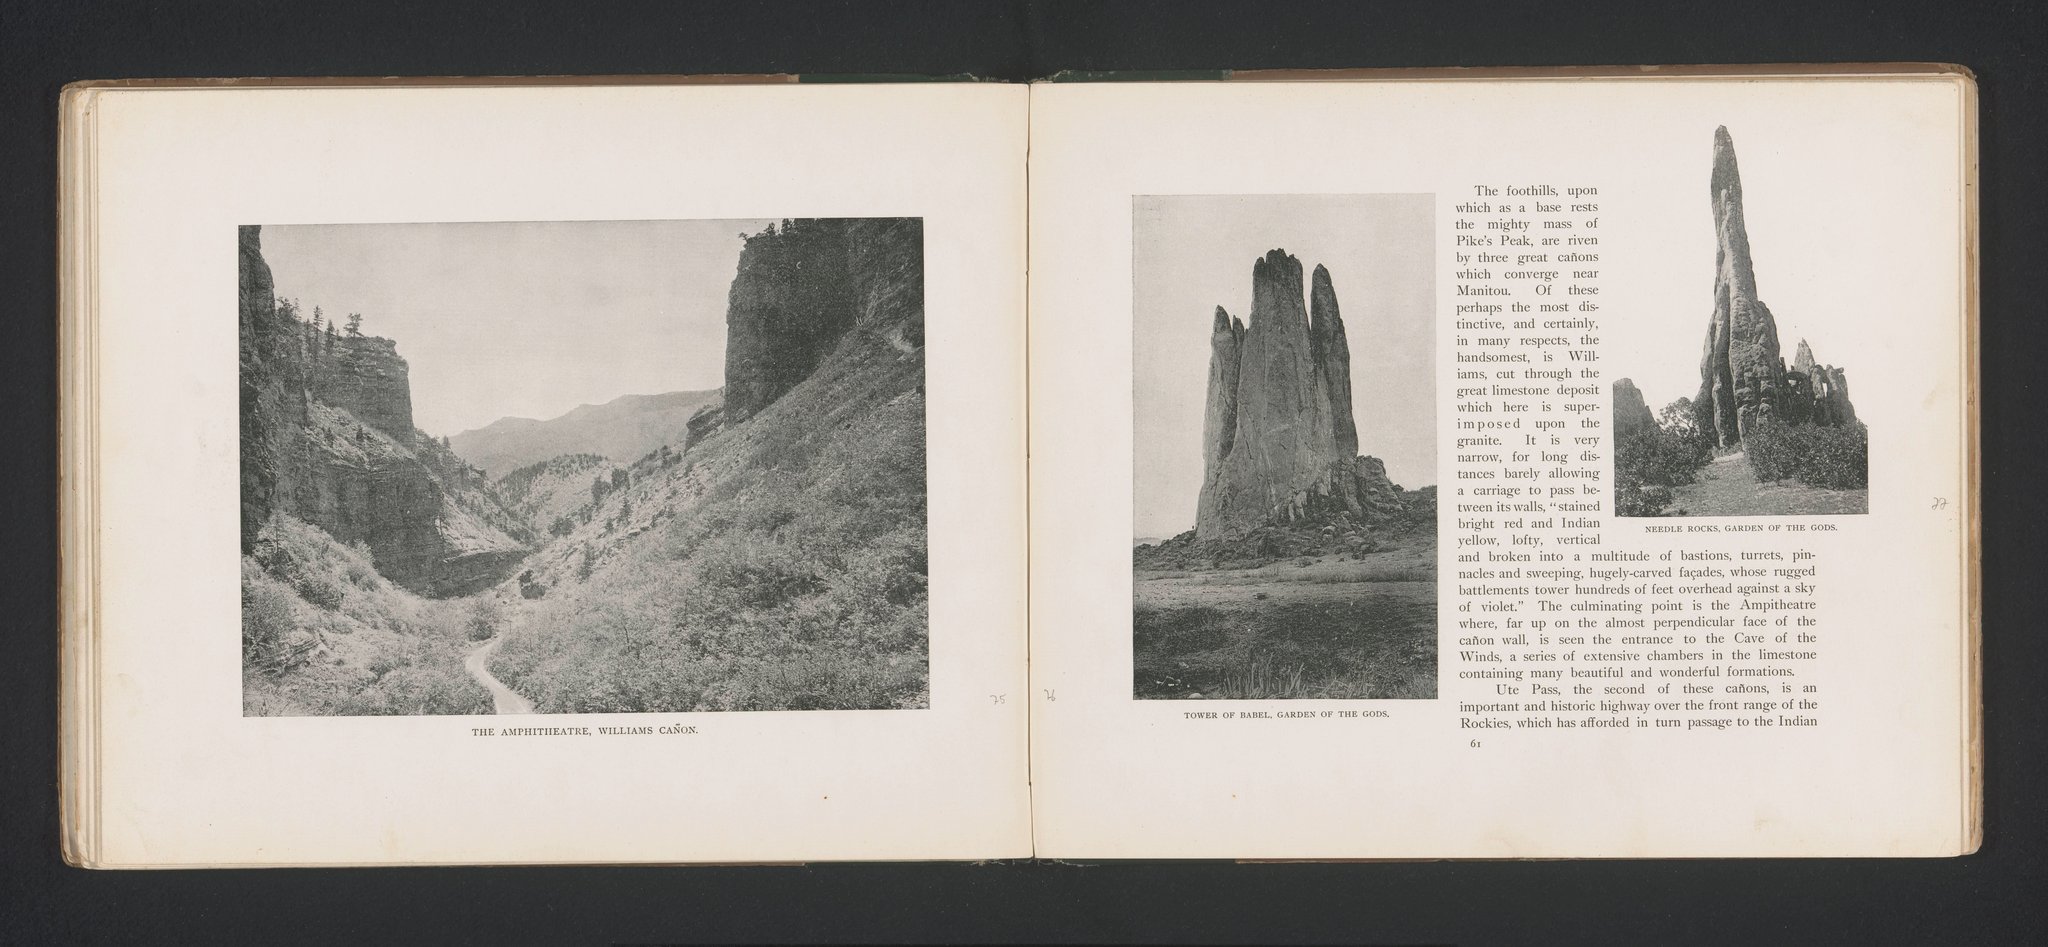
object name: page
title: Gezicht op de Needle Rocks in de Tuin der Goden te Colorado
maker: Anonymous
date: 1888-1893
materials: paper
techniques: autotype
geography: new york city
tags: landscapes, ravine, chasm, abyss, canyon